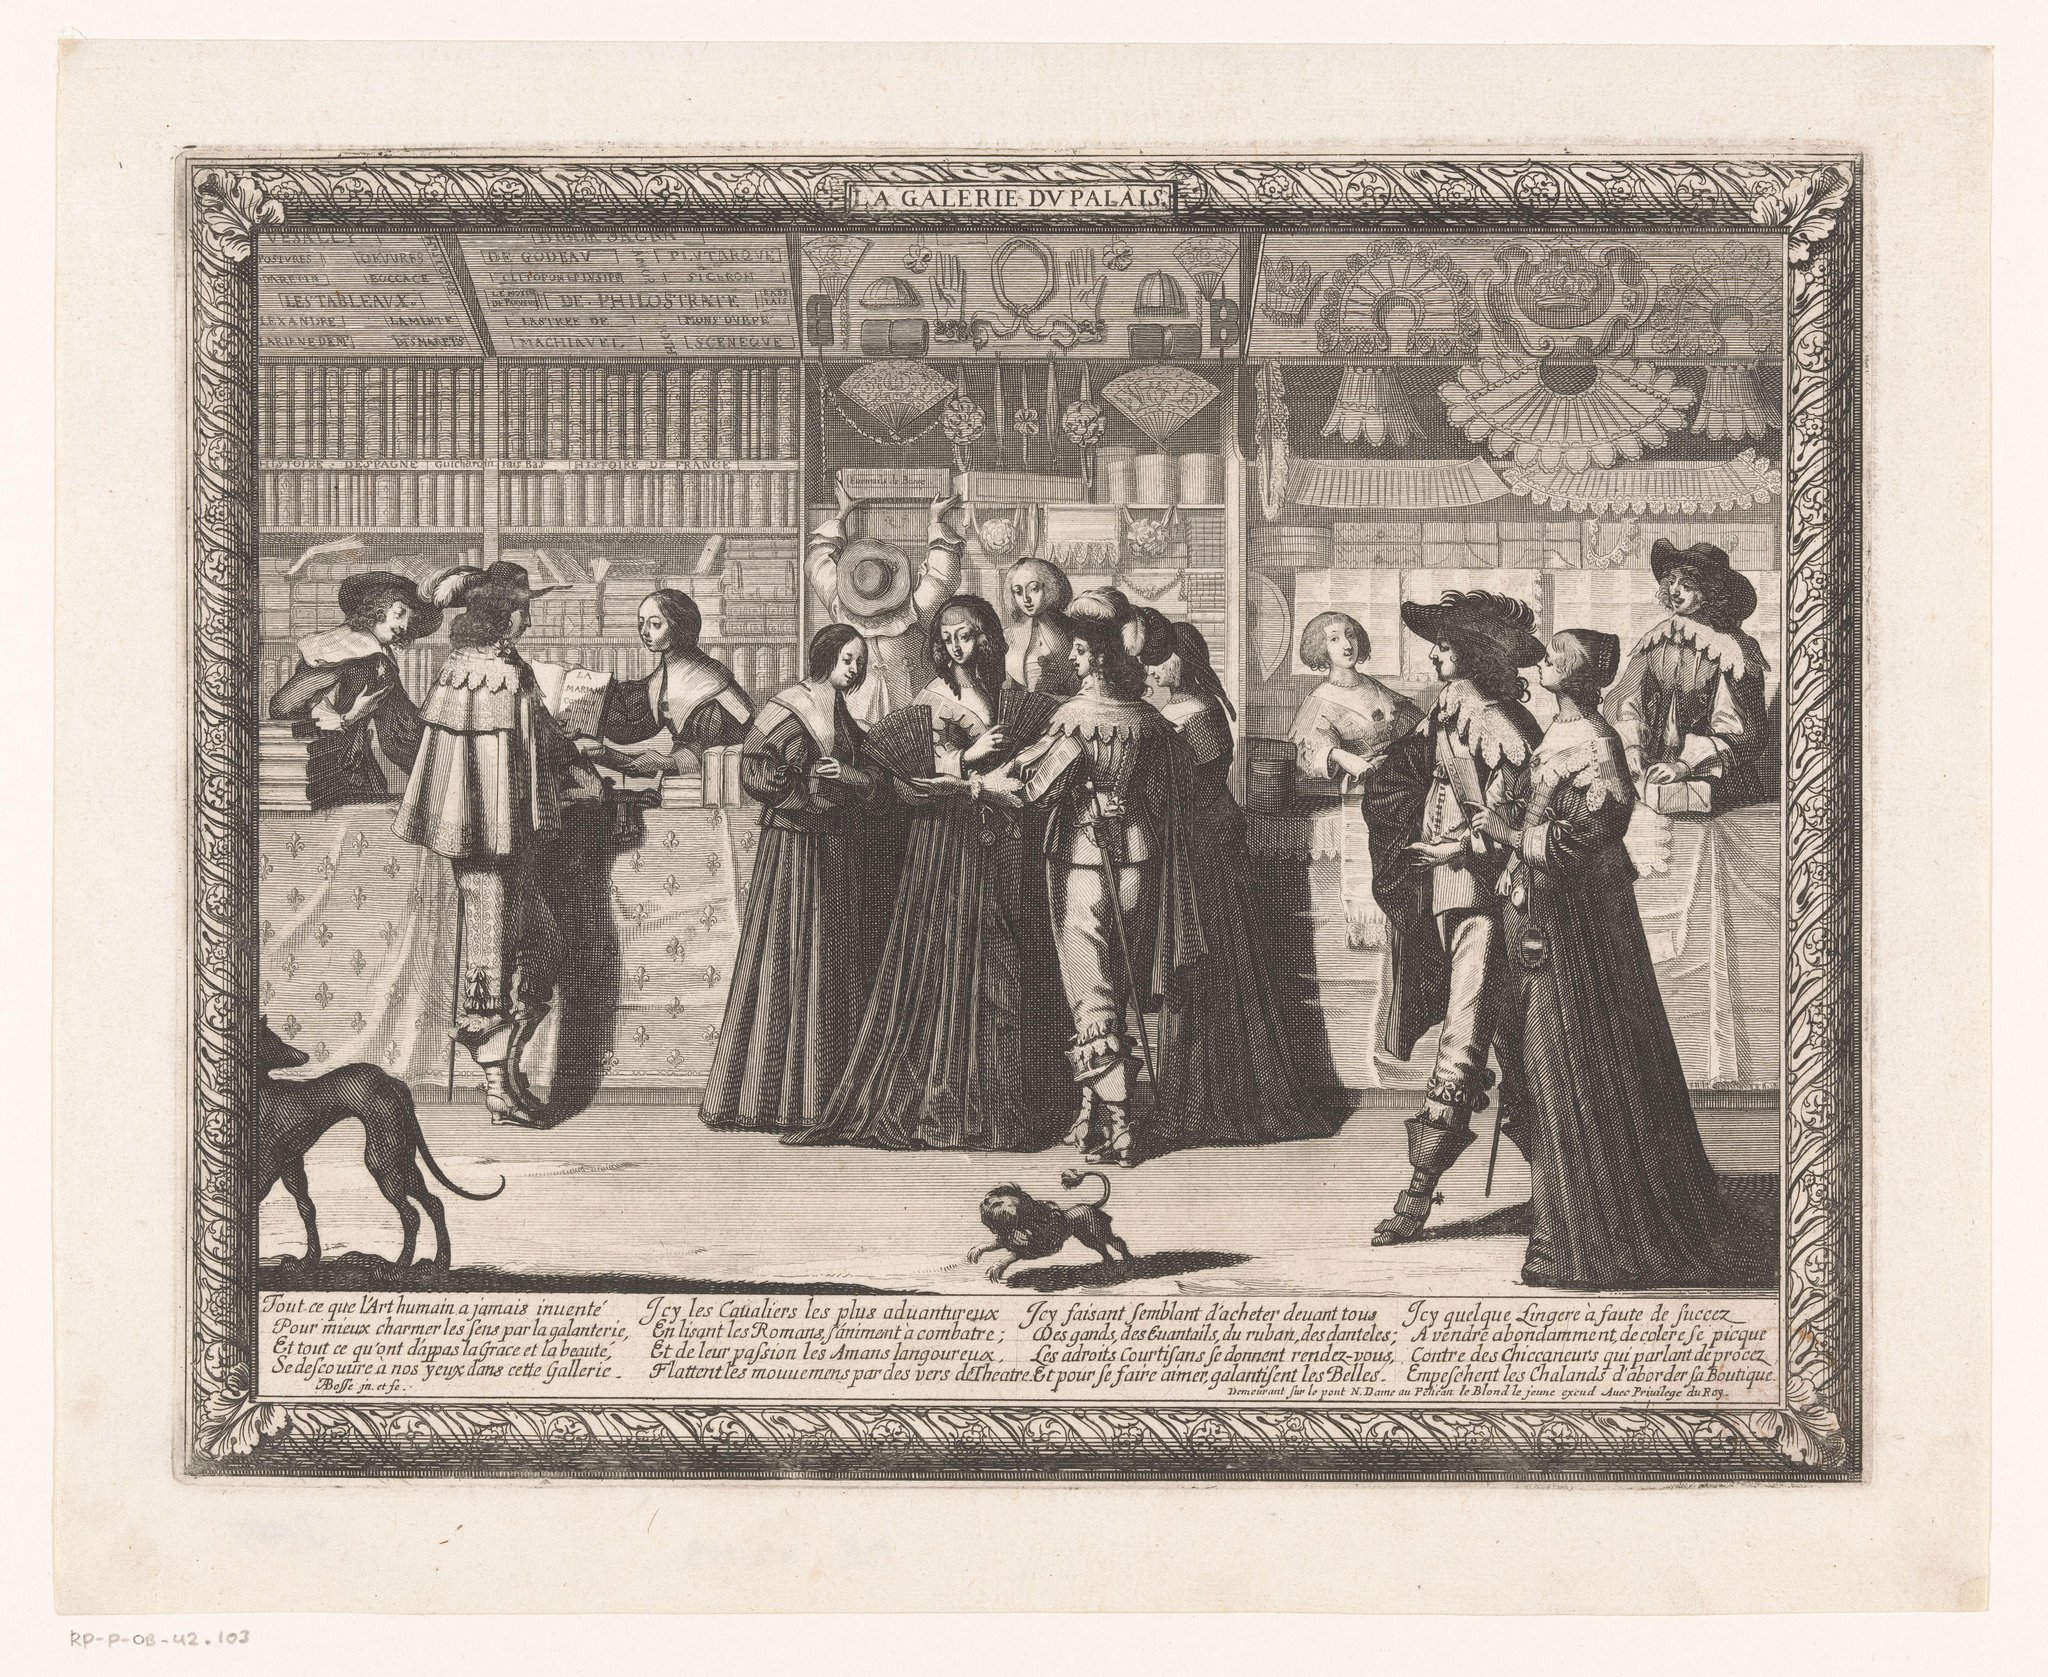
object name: print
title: Galerie du Palais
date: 1637-1638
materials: paper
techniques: engraving, etching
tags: shop, store, head-gear: hat (+ men's clothes), neck-gear: collar (+ women's clothes), clothes, costume (+ women's clothes), accessories (~ clothing), gloves, mittens, etc. (+ women's clothes), clothes, costume (+ men's clothes), neck-gear: collar (+ men's clothes), table-cloth, gloves, mittens, etc. (+ men's clothes), book-shop, bookseller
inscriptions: collector's mark: Lugt 240, caption: ‘Tout ce que l'Art humain a jamais inventé / Pour mieux charmer les sens par la galanterie / Et tout ce qu'ont d'appas la Grace et la beauté, / Se descouvre à nos yeux dans cette Gallerie. // Icy les Cavaliers les plus advantureux / En lisant les Romans, s'animent à combatre; / Et de leur passion les Amans langoureux, / Flattant les mouvements par des vers de Theatre. // Icy faisant semblant d'acheter devant tous / Des gands, des Evantails, du ruban, des danteles; / Les adroits Courtisans se donnent rendez-vous, / Et pour se fair aimer, galantisent les Belles. // Icy quelque Lingere à faute de succez / A vendre abondamment de colere se picque / Contre des Chiccaneurs qui parlant de procez / Empeschent les Chalands d'aborder sa Boutique.’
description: With over 200 shops the Galerie du Palais was the epicentre of luxury merchandise in Paris and the place par excellence for well-to-do people to meet. At the left is a bookshop, while at the right people gape at lingerie, lace collars and cuffs. The centre shop sells fans, gloves, and accessories. A number of ladies wear a short and very fashionable pearl necklace.